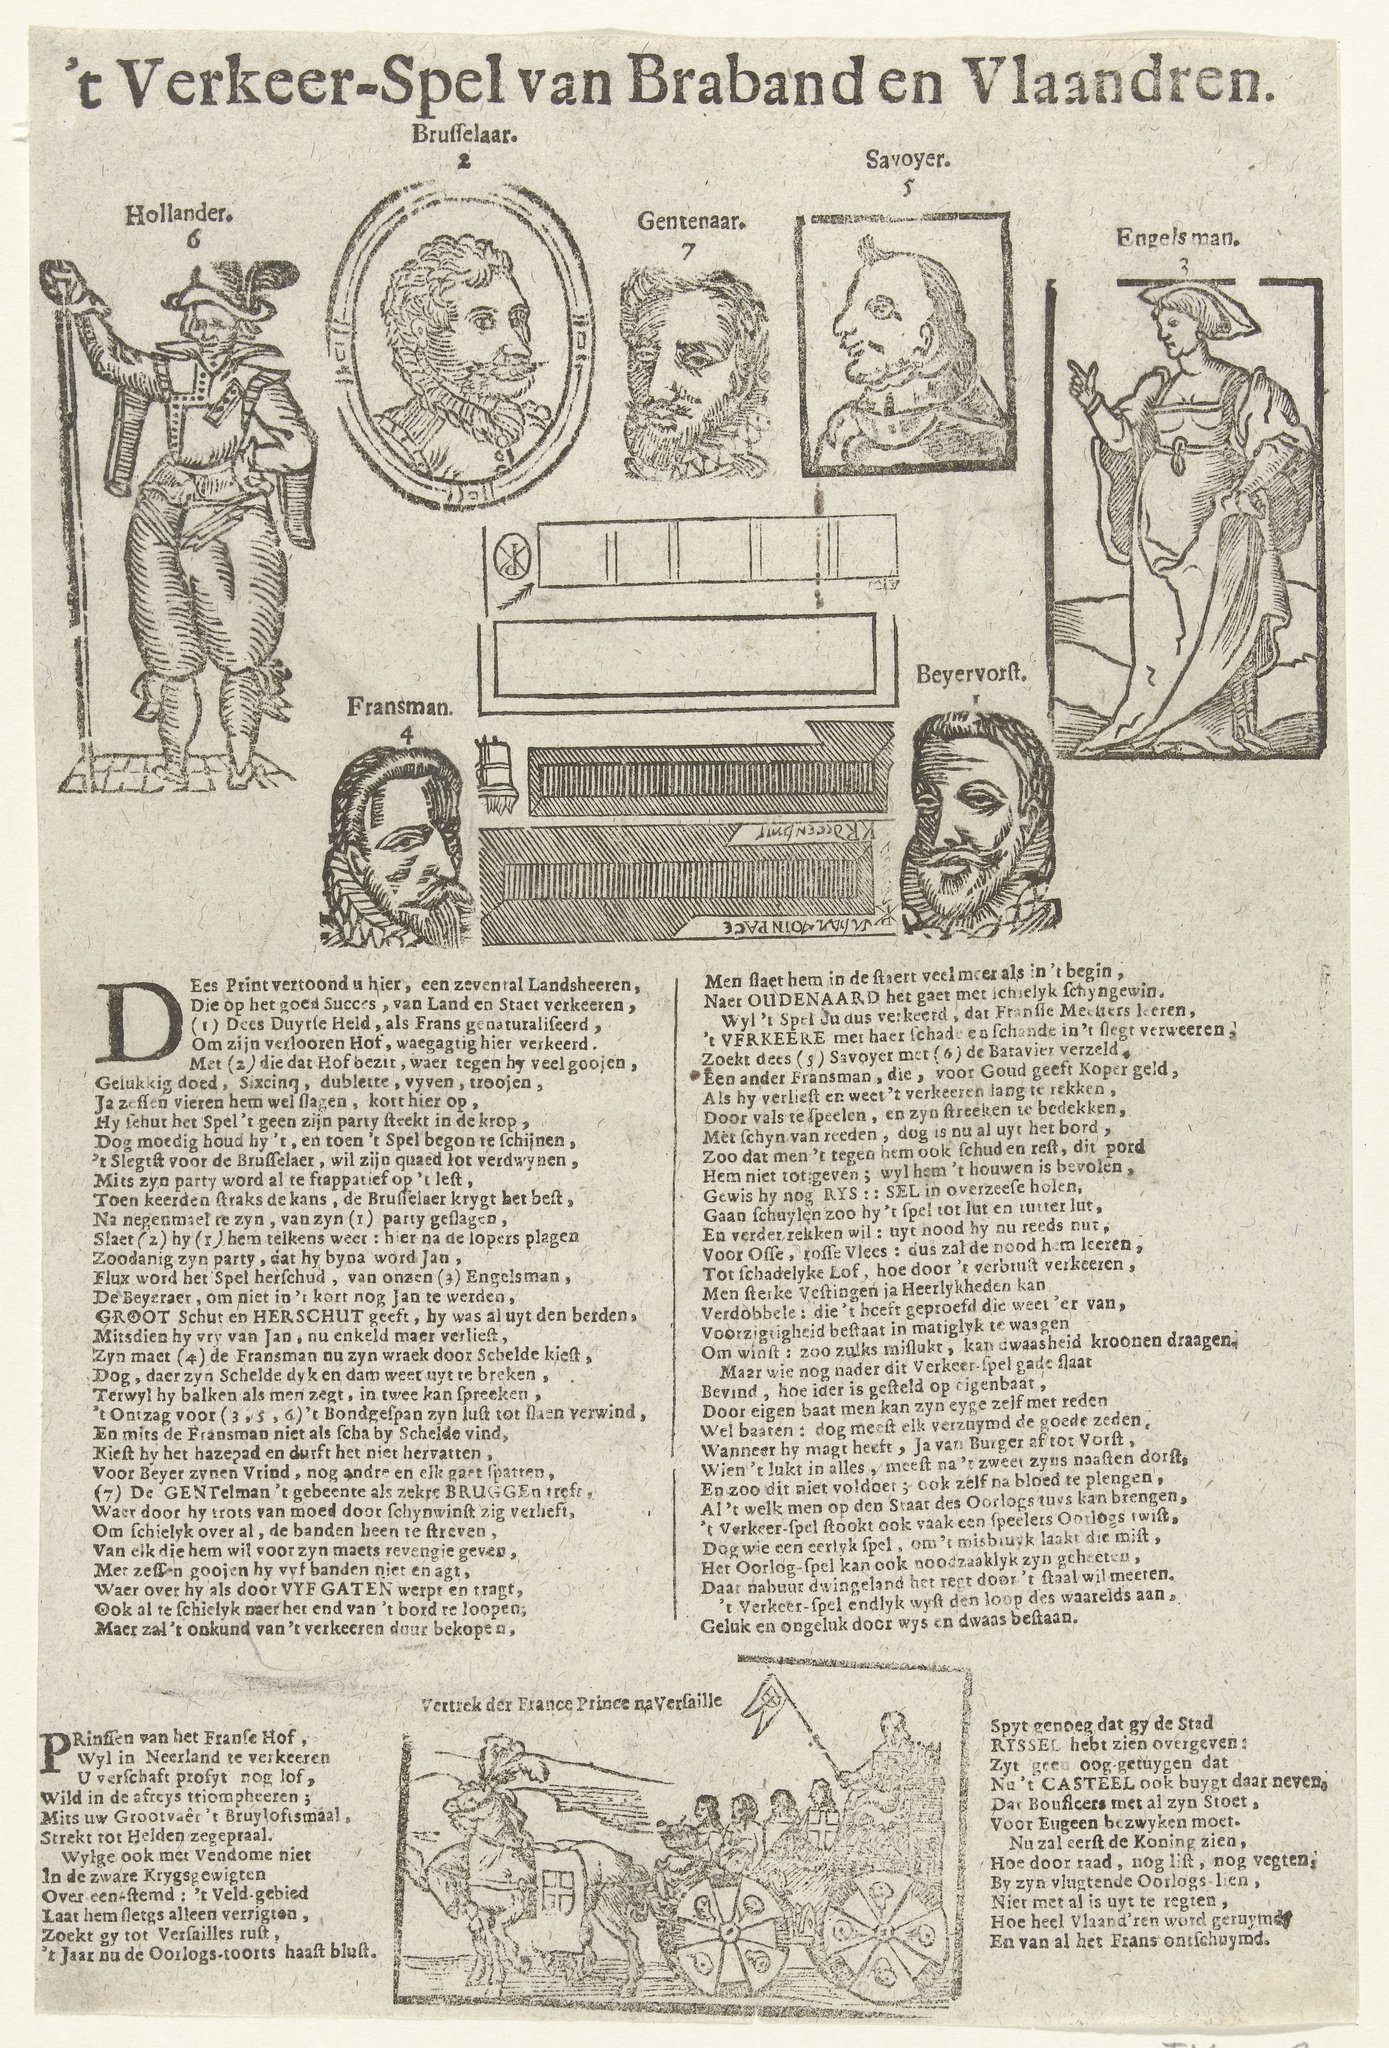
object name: print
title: Het Verkeersspel van Brabant en Vlaanderen, 1708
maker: Anonymous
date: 1708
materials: paper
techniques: letterpress printing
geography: northern netherlands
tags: spaanse successieoorlog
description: Spotprent op de Franse verliezen in 1708. Blad samengesteld uit zeven verschillende gemonteerde koppen in houtsnede en enkele teksten. Onderdeel van een groep afzonderlijke spotprenten op Lodewijk XIV tijdens de Spaanse Successieoorlog, ca. 1701-1713.